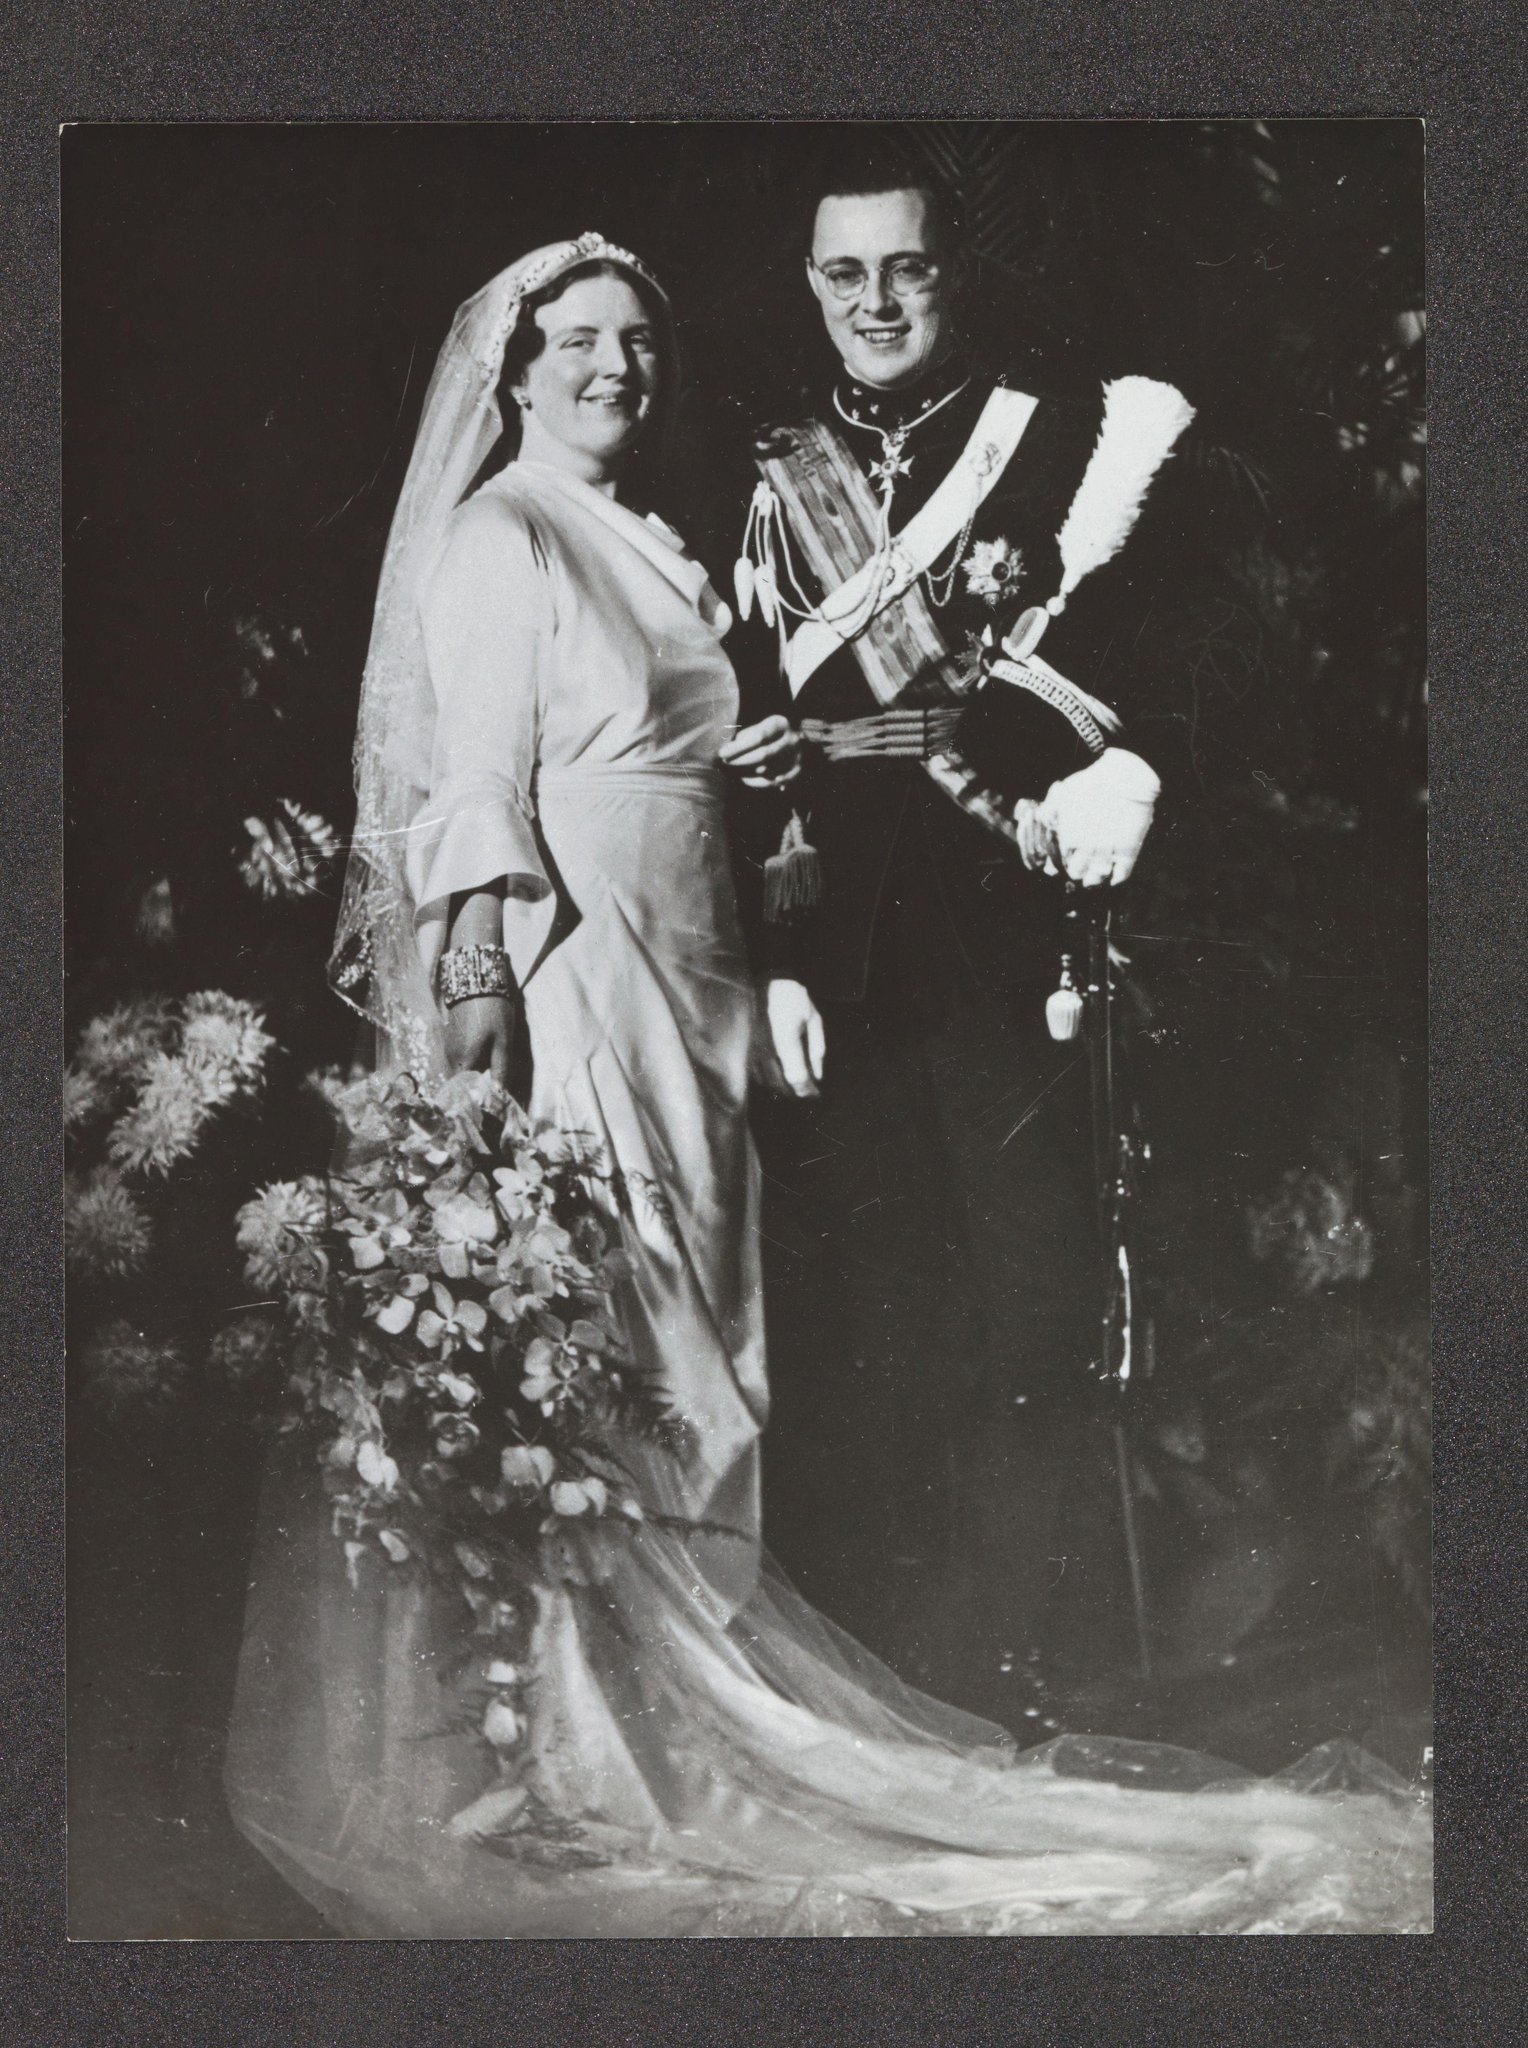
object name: photograph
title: Huwelijksportret van Koningin Juliana en Prins Bernhard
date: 1937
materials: paper, photographic support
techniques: gelatin silver print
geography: netherlands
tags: utrecht, bernhard (prins der nederlanden), juliana of the netherlands, the hague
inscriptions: stamp: ‘copyright Anefo Kerkstraat 310 Amsterdam-C no 78a’